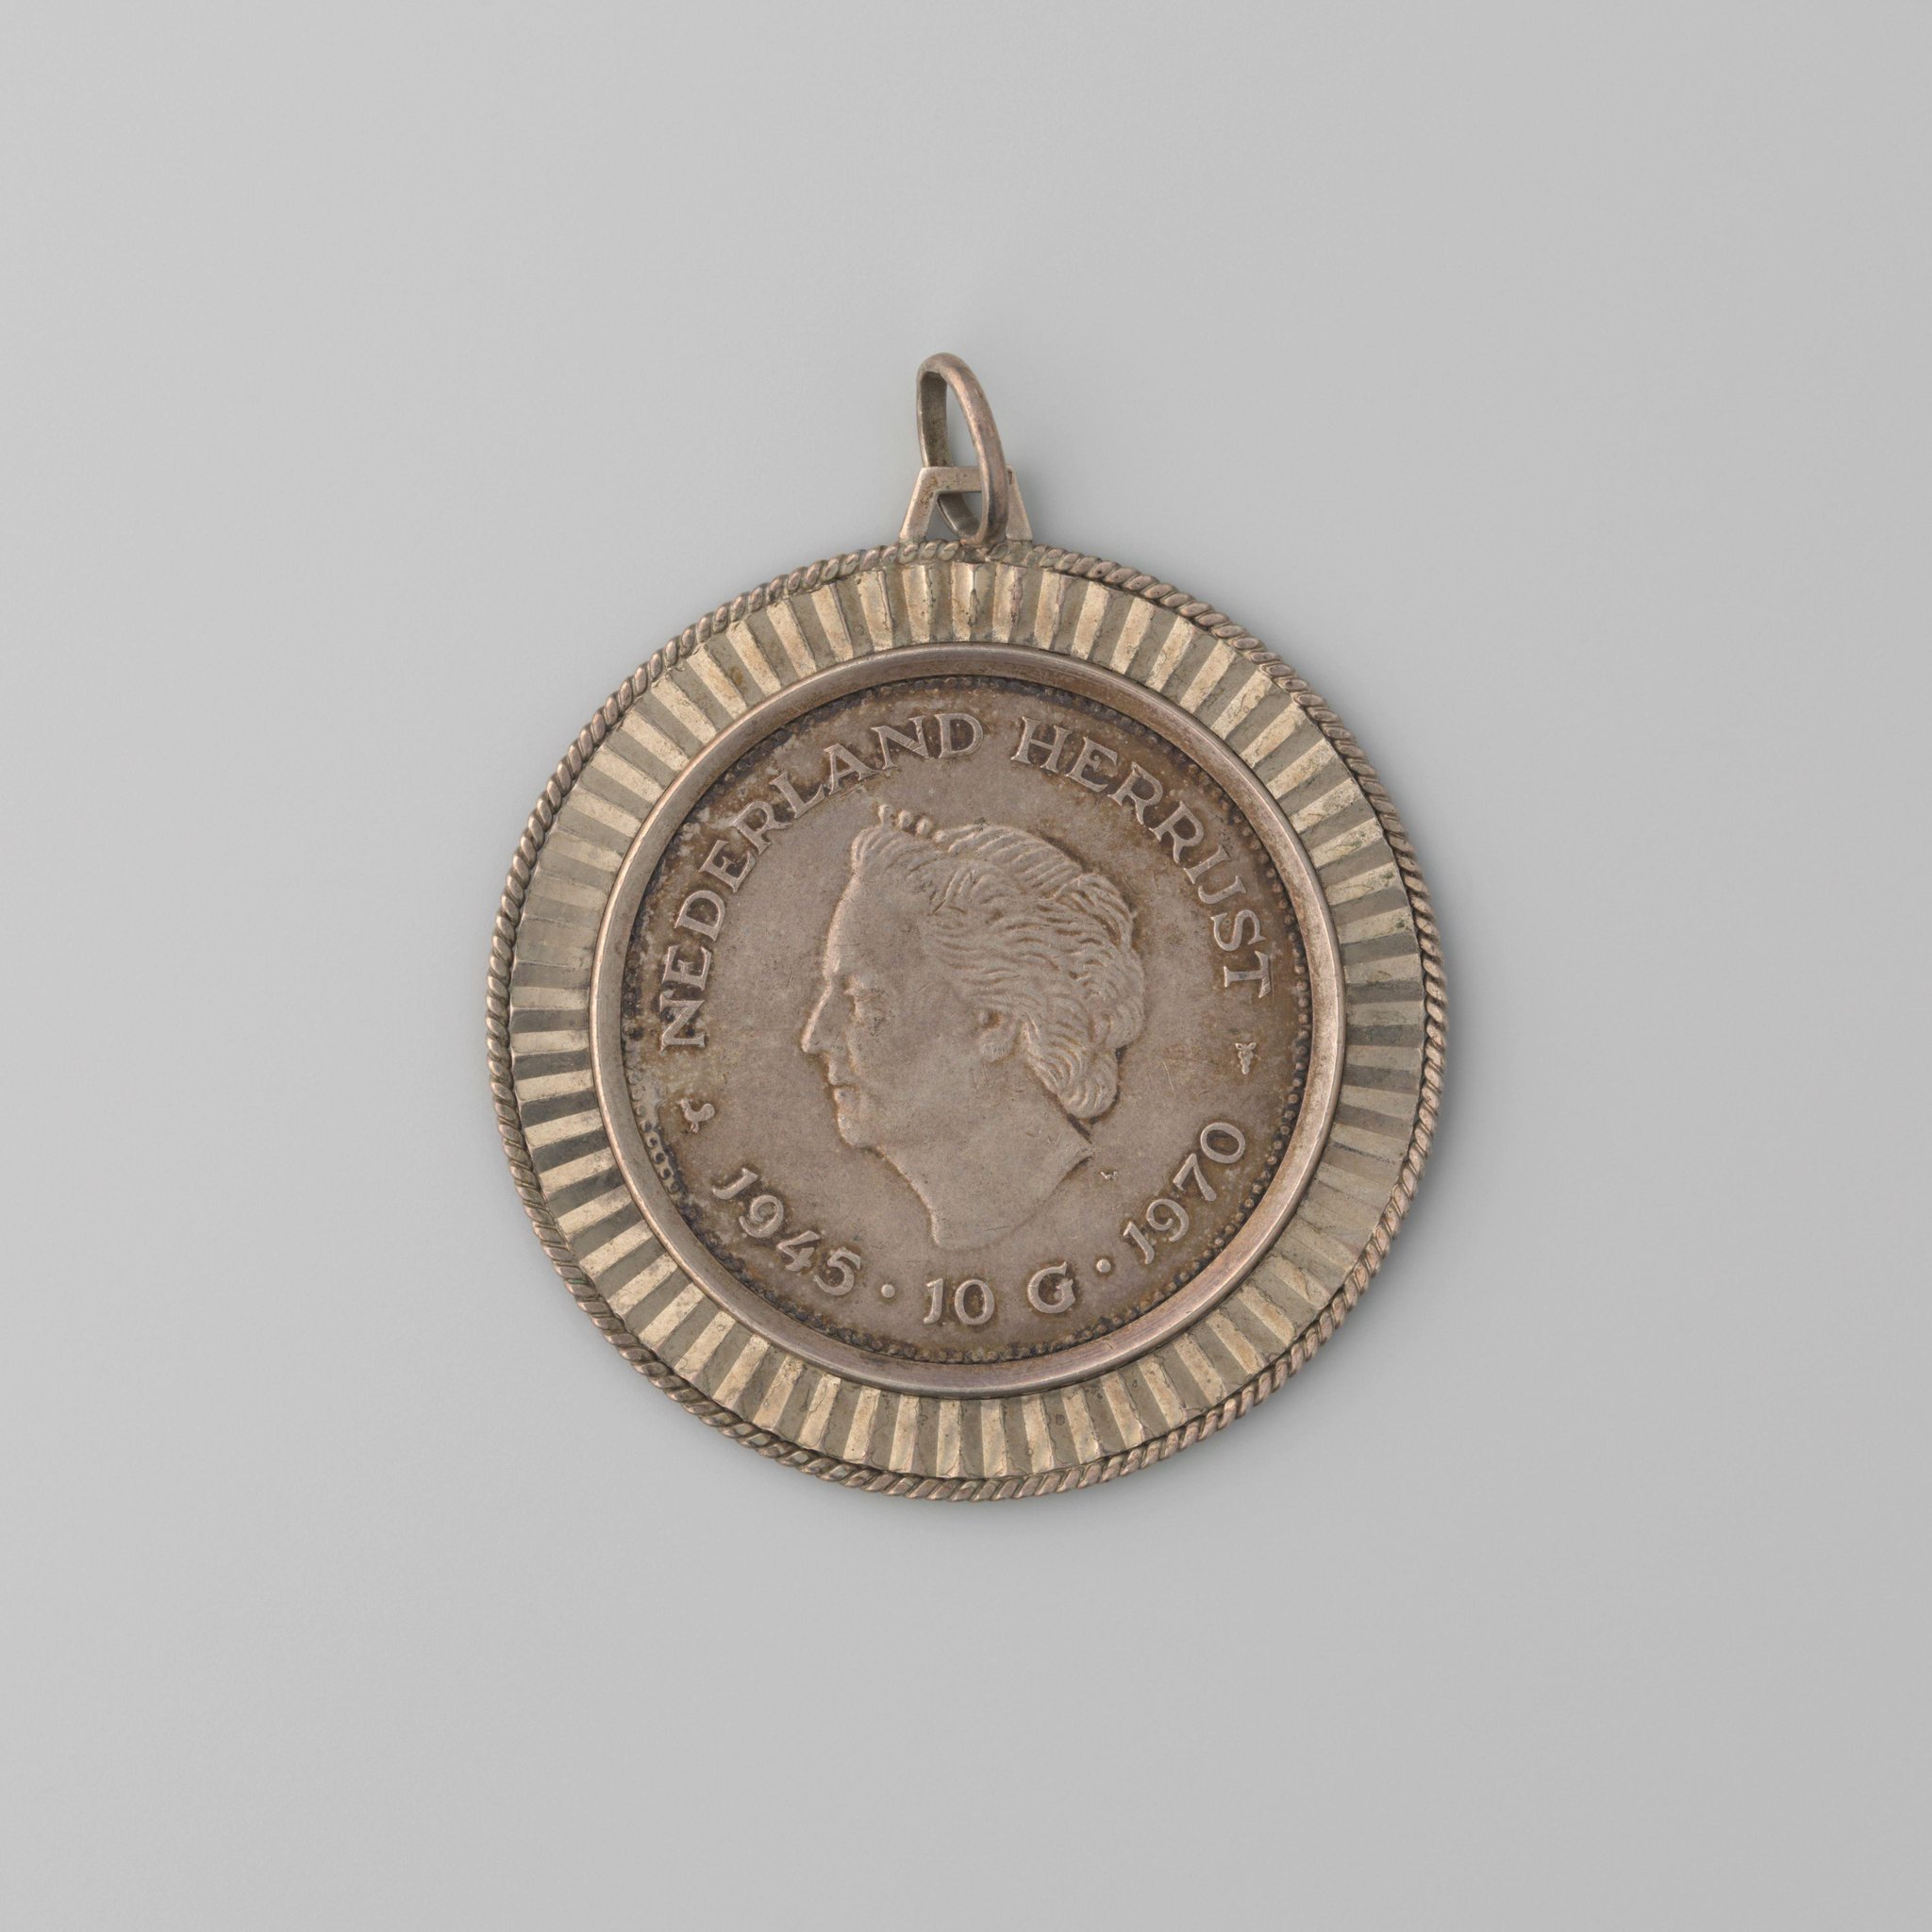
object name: coin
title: Hanger met zilveren tientje over het regeringsjubileum van koningin Juliana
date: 1970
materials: silver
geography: rotterdam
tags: the hague, juliana of the netherlands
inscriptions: inscription: ‘JULIANA KONINGIN DER NEDERLANDEN’, inscription: ‘NEDERLAND HERRIJST 1945 10 G 1970’, import mark: ‘SGI+’, : ‘ZII’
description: Hanger met zilveren tientje, over het 25-jarig regeringsjubileum van koningin Juliana 1945-1970, in een rand voorzien van een plaatoog.